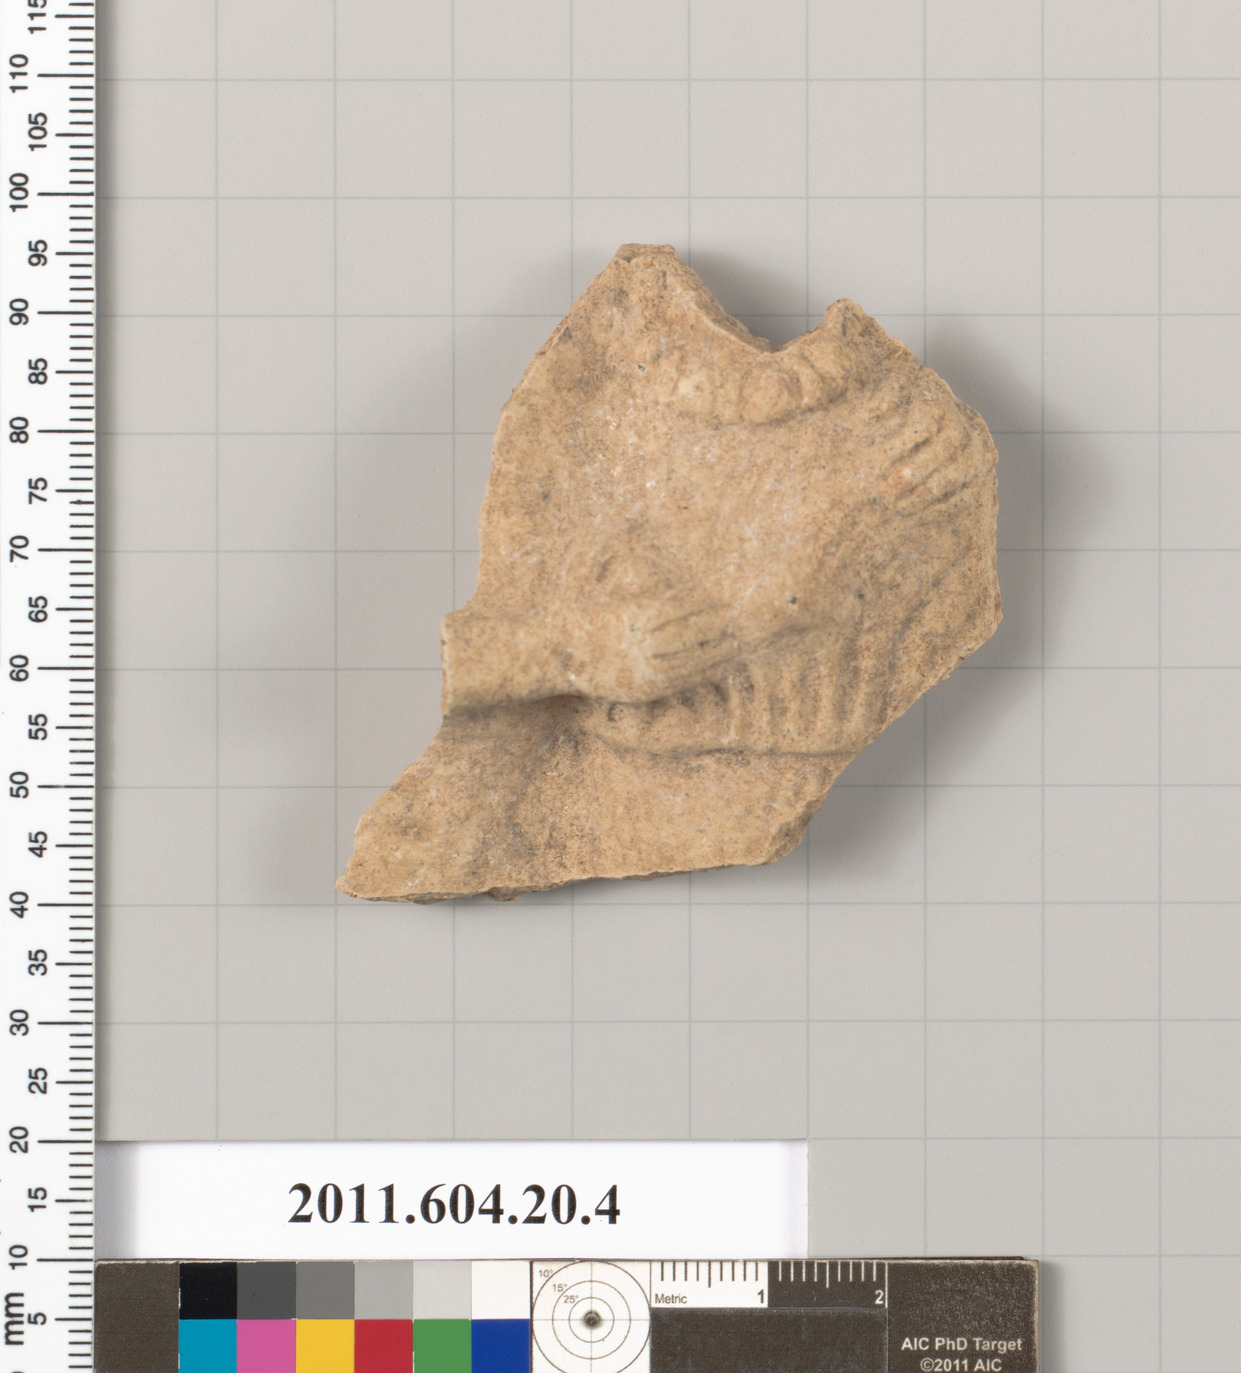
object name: statuette fragment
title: Fragment of a statuette of a woman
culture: greek, attic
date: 400-201 BCE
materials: terracotta